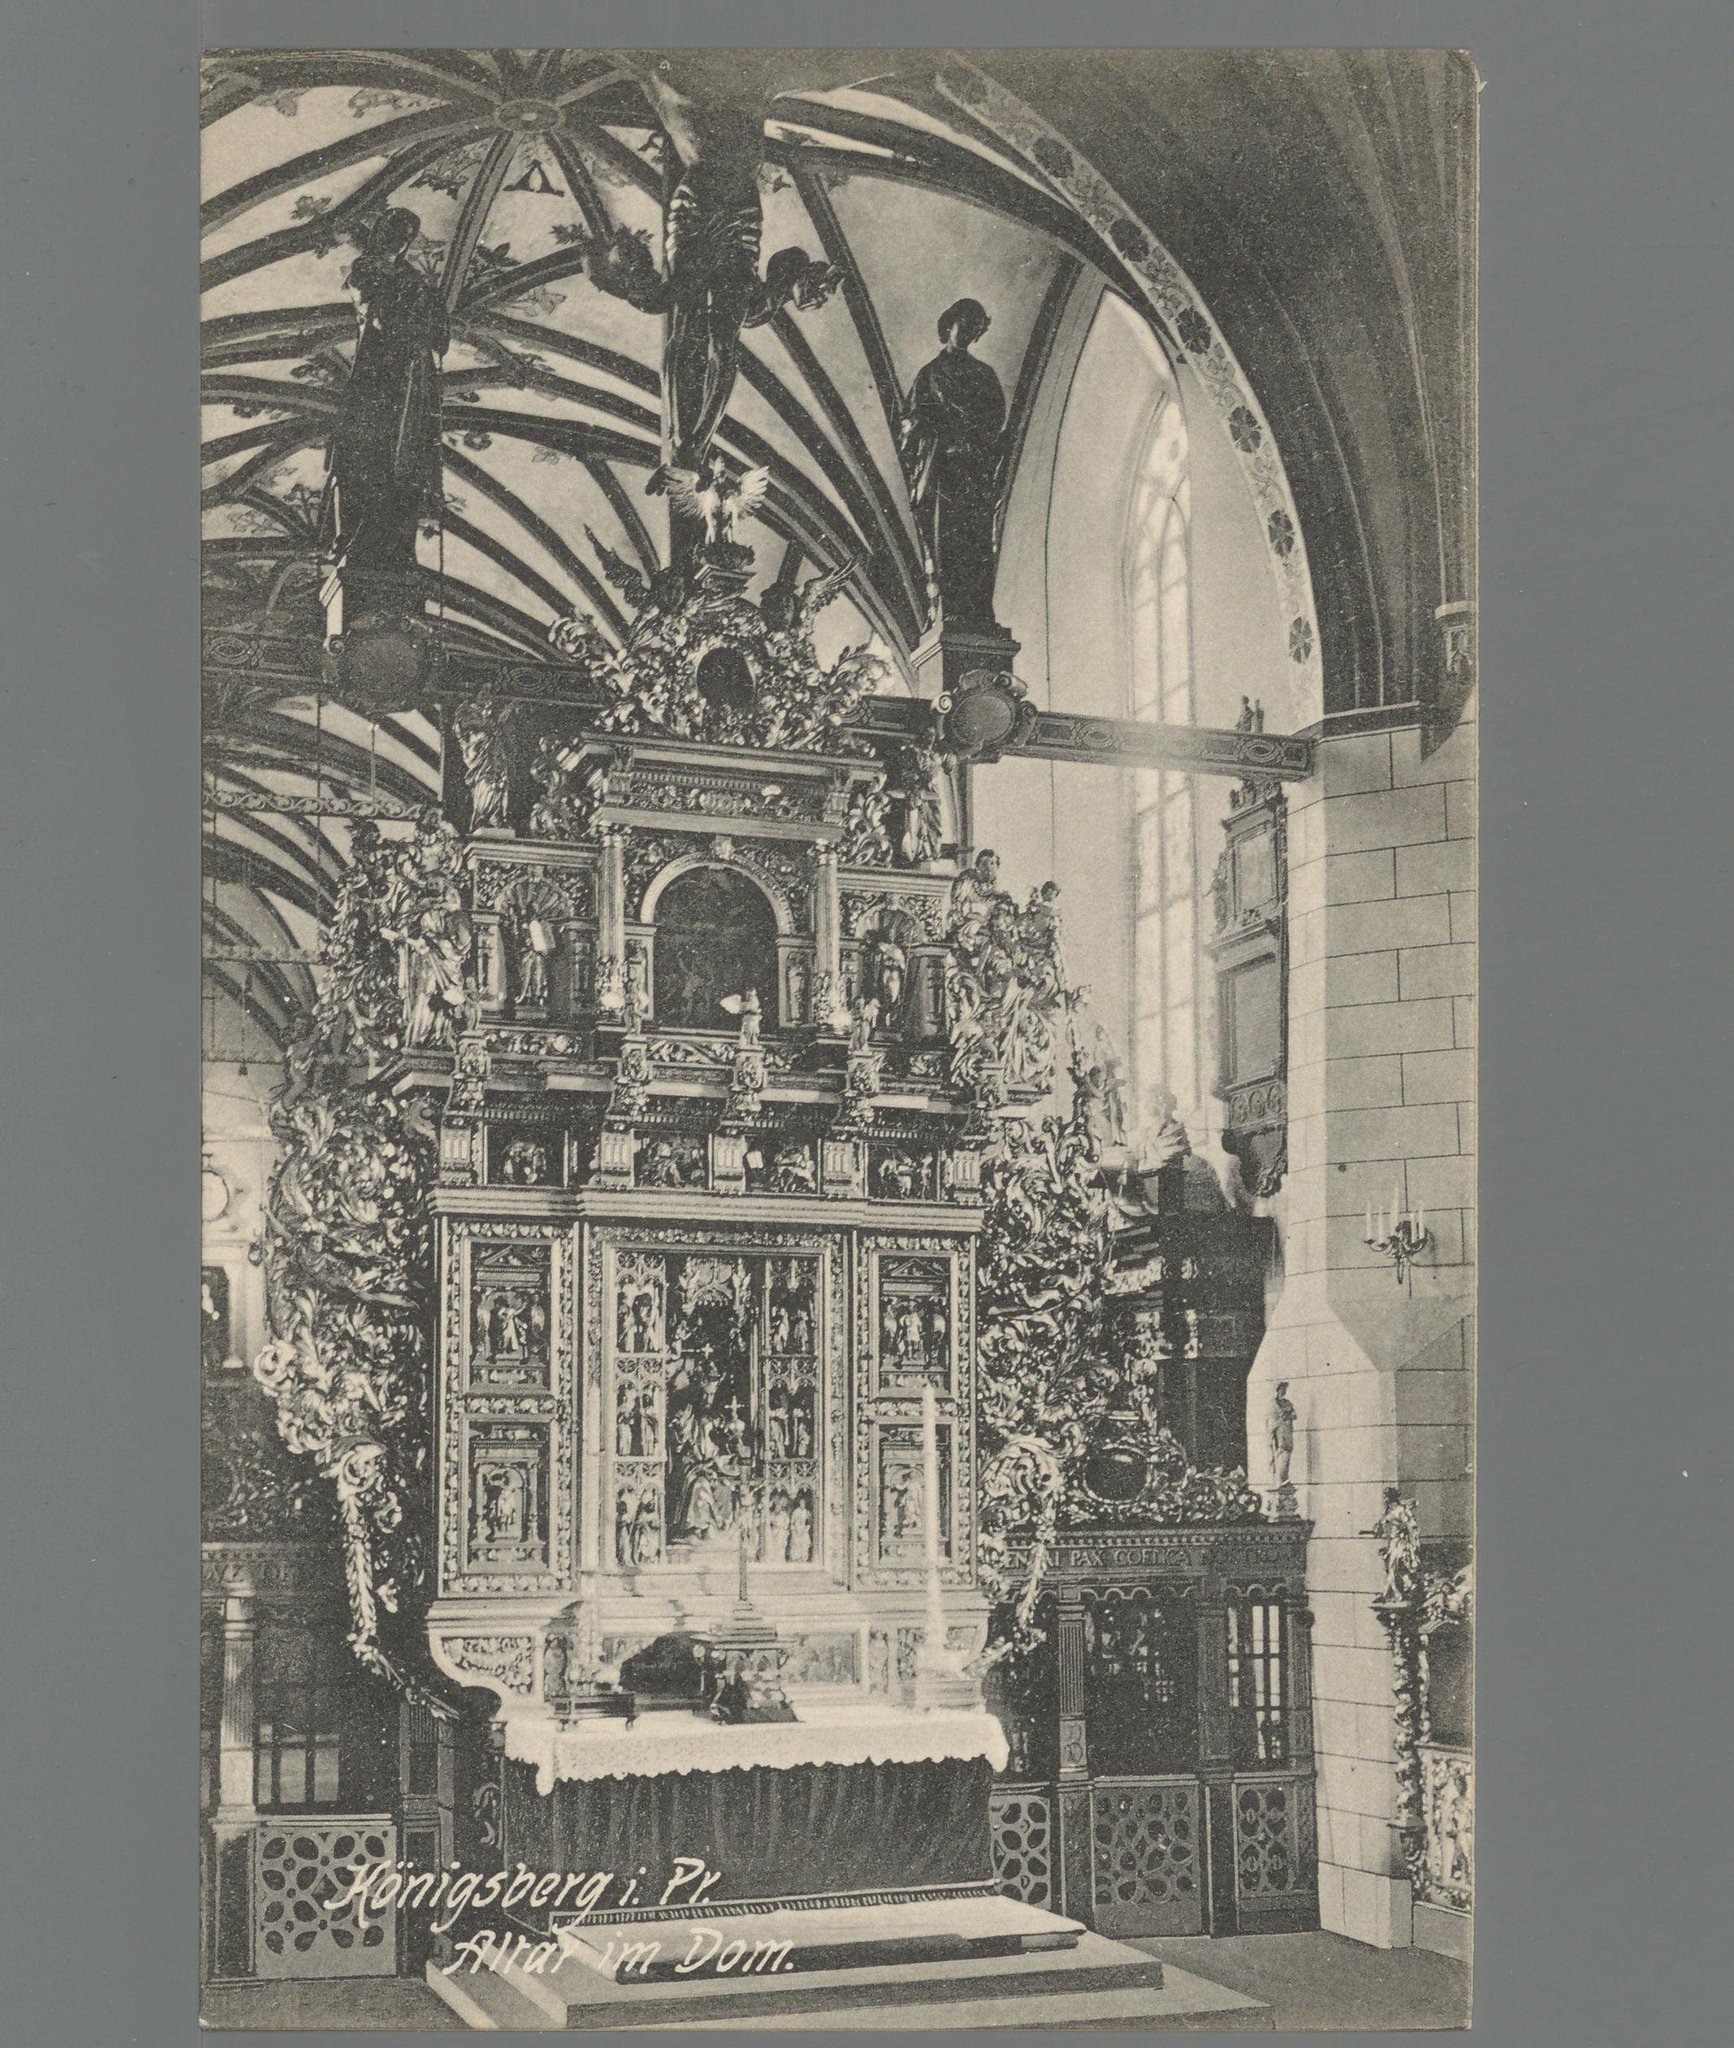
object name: photomechanical print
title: Königsberg i. Pr. Altar im Dom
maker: Anonymous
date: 1908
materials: cardboard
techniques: photograph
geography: königsberg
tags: interior of church, altar with altar-piece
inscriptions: date